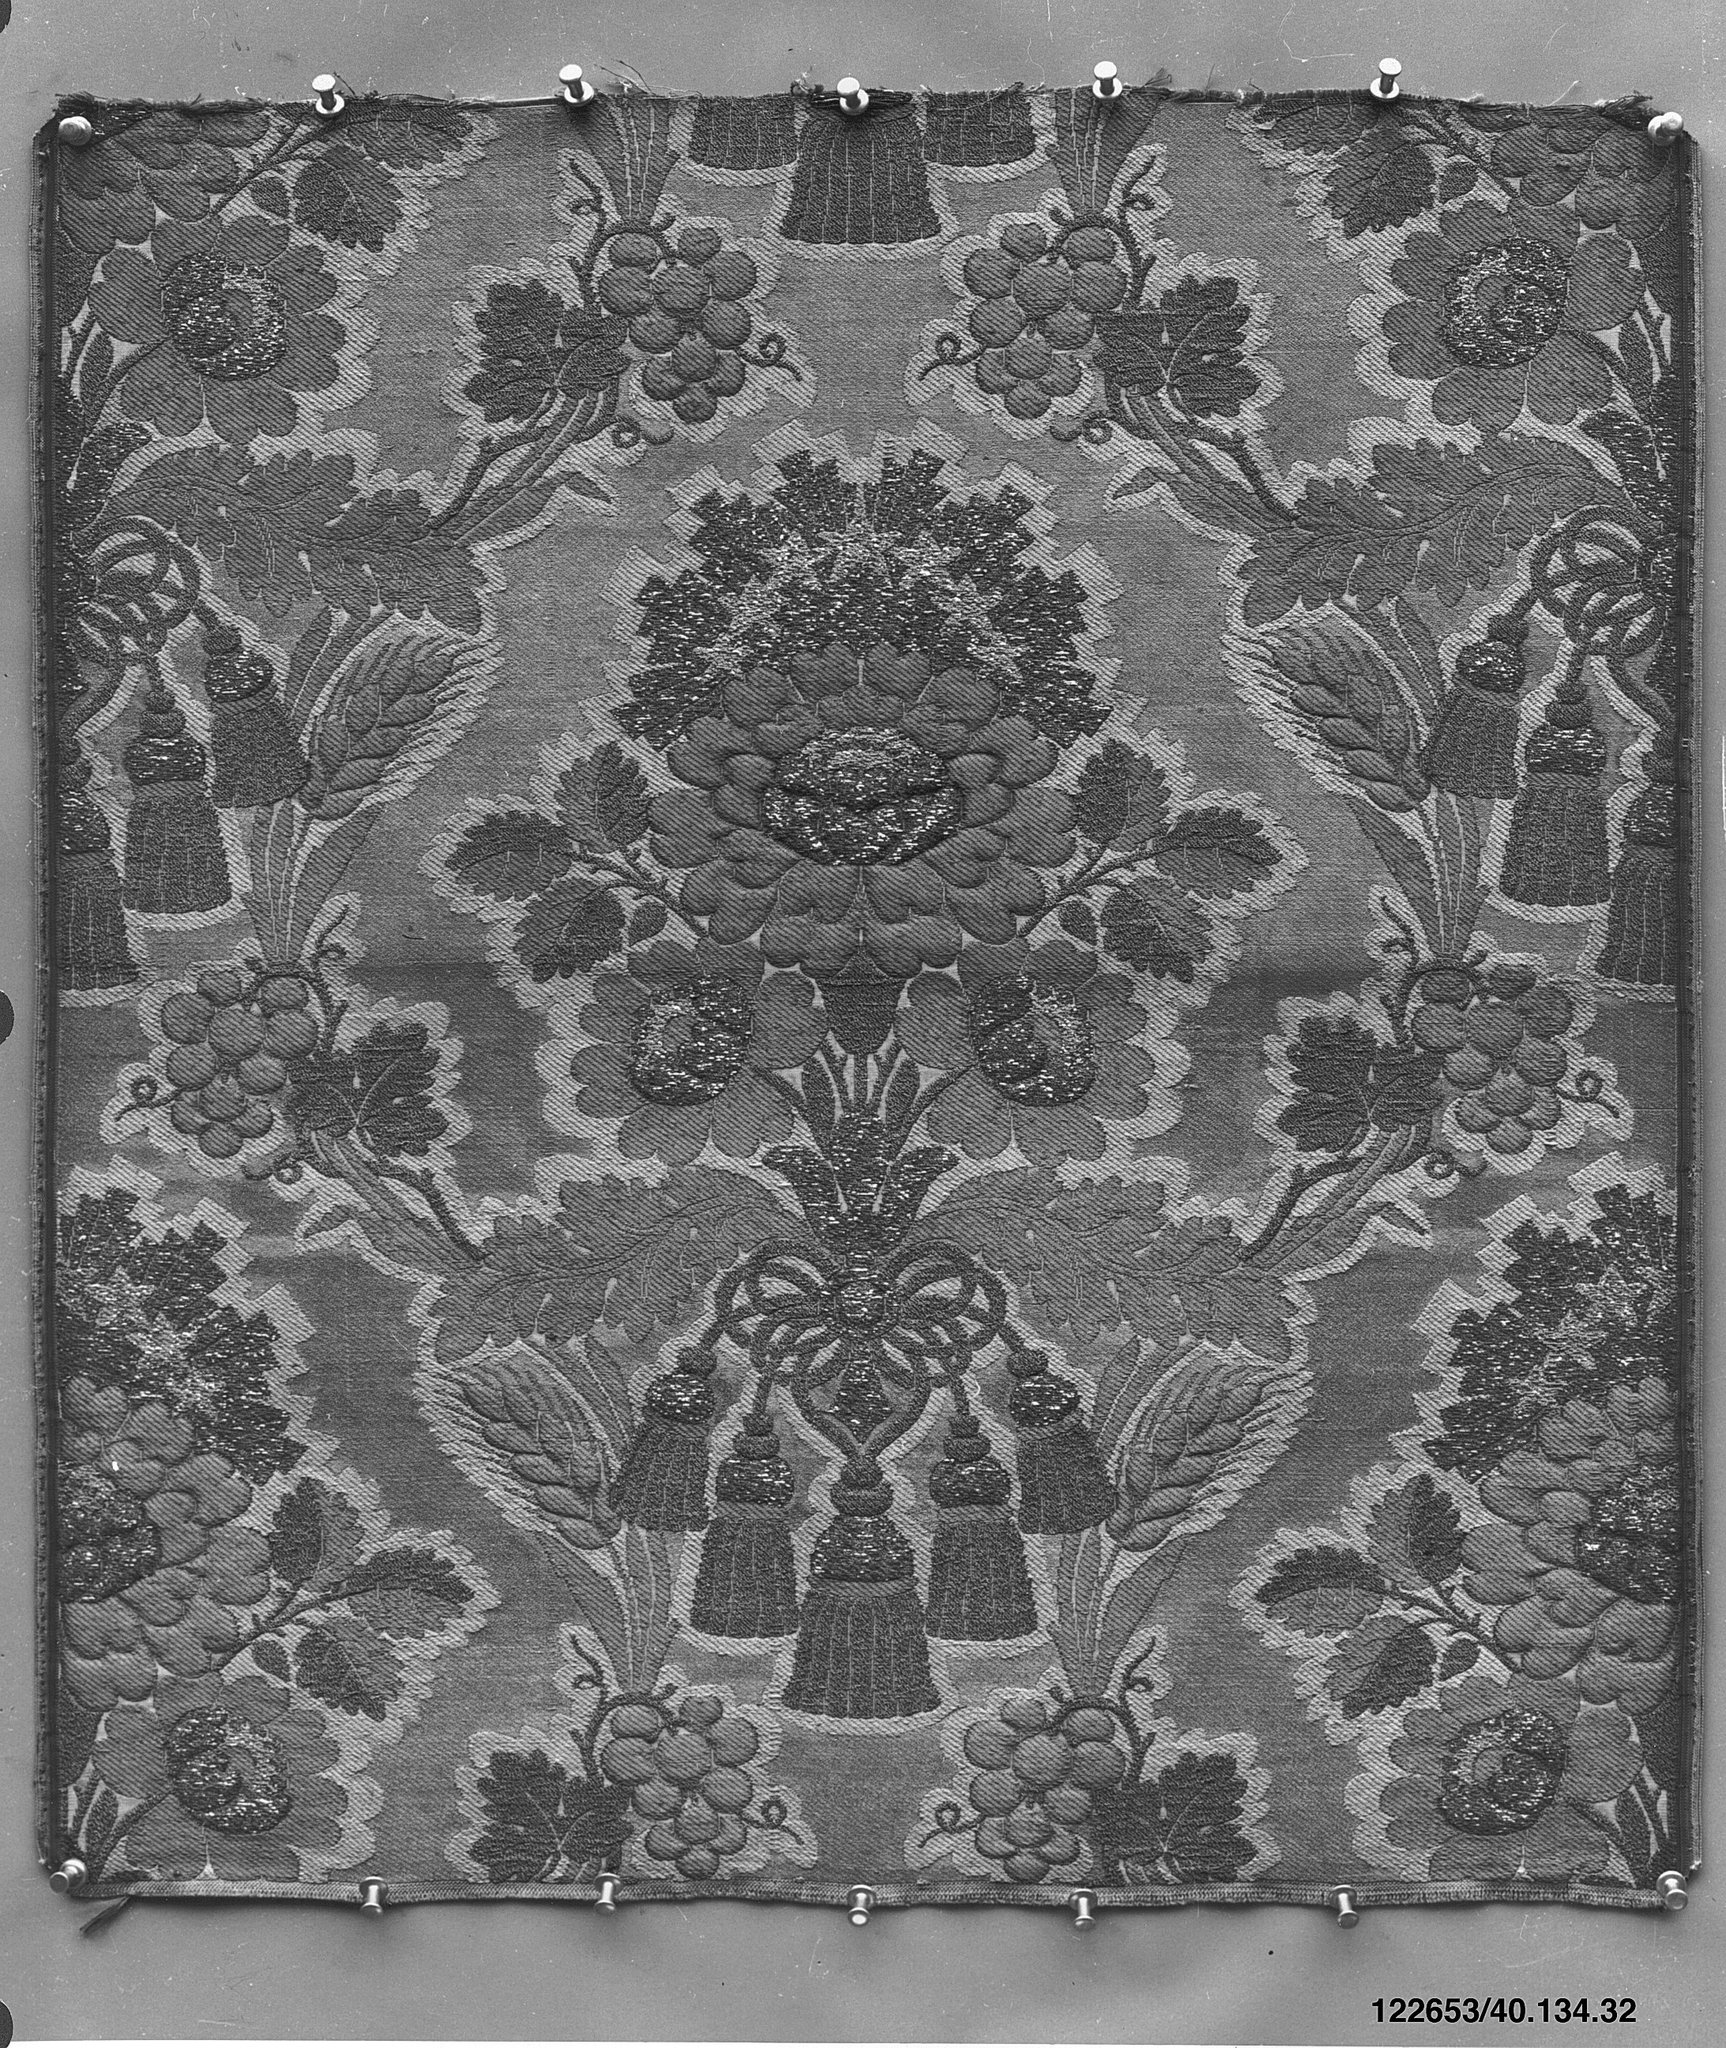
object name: piece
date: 1701-1900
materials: metal thread, silk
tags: fruit,flowers,leaves